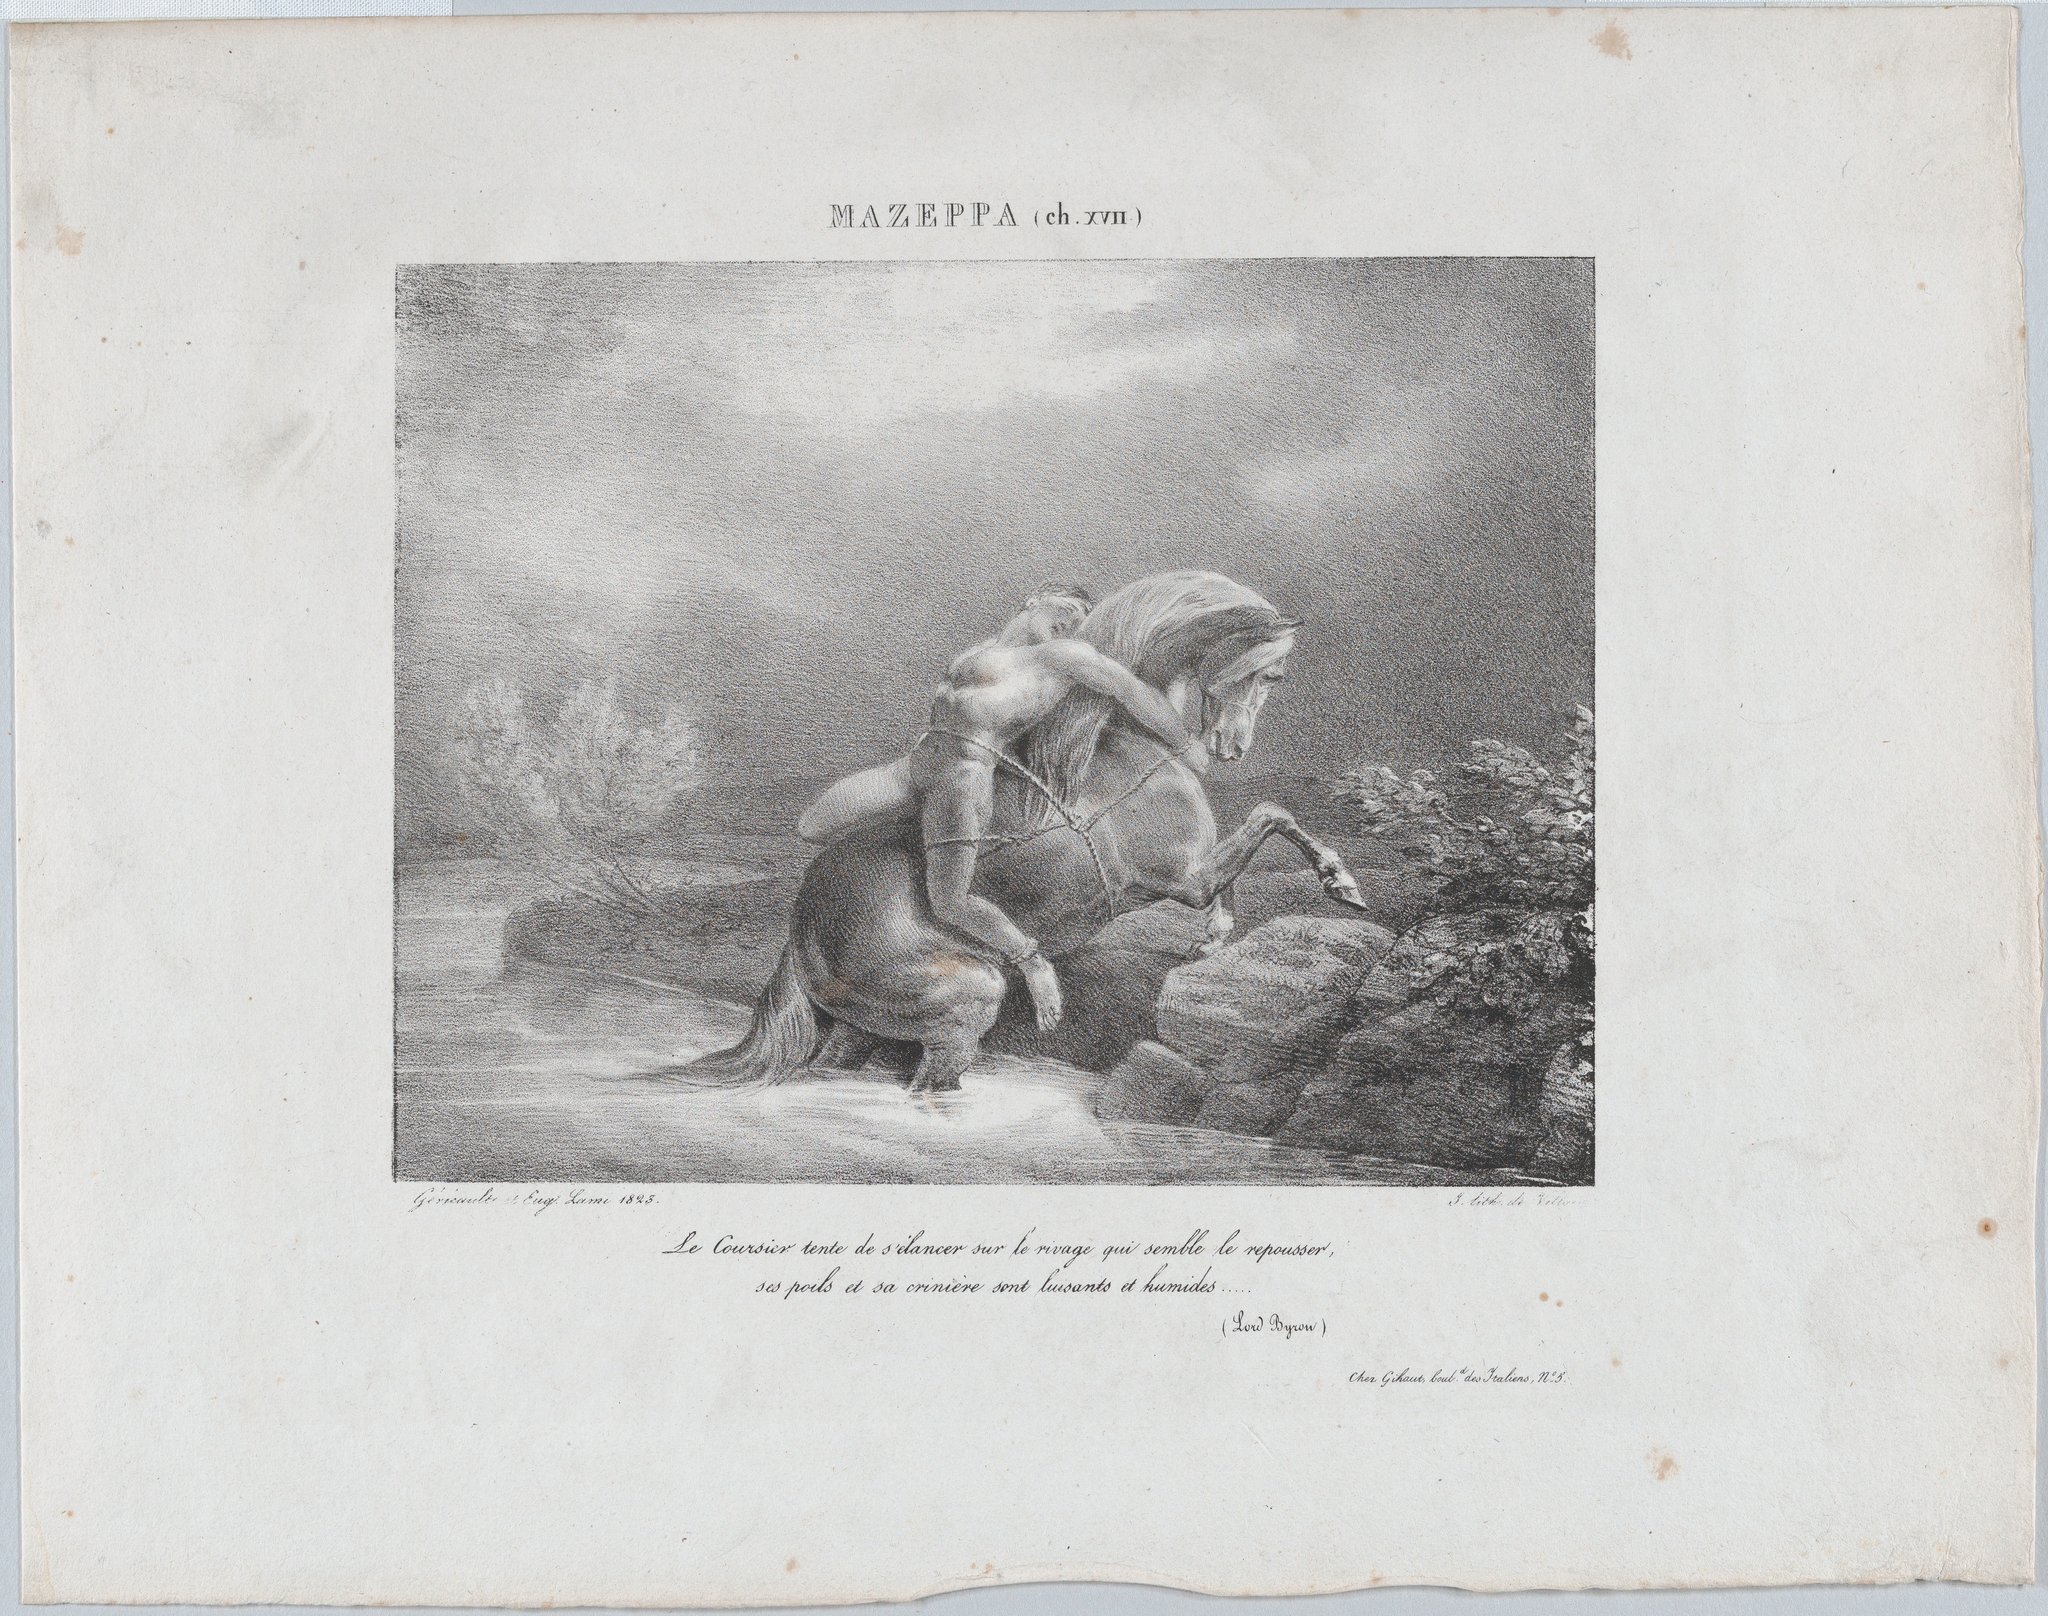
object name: print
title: Mazeppa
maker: jean louis andré théodore géricault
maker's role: artist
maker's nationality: french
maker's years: 1791-1824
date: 1823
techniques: lithograph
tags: poetry,male nudes,horses,plants